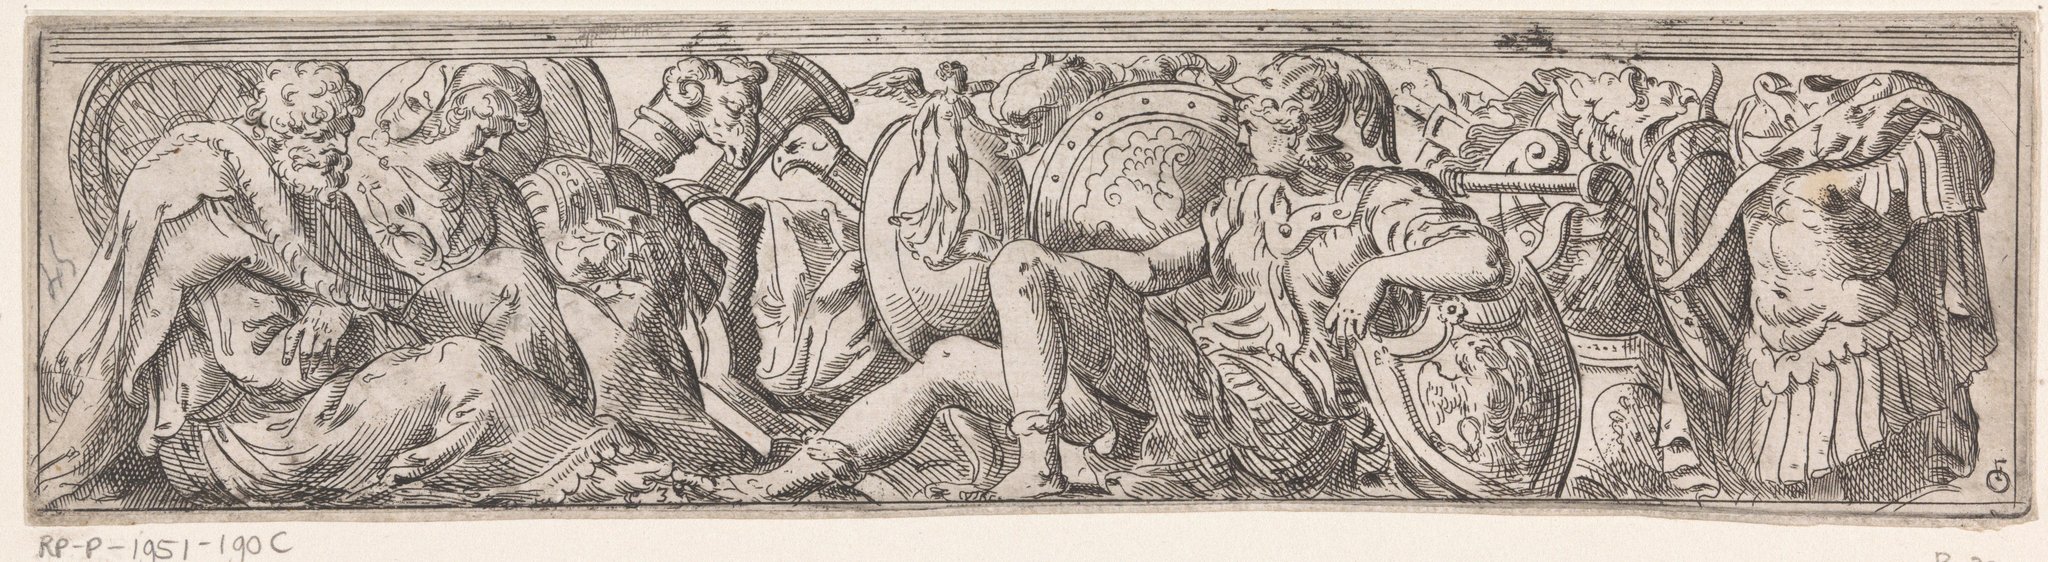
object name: print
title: Figuren tussen wapens en vazen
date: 1583-1638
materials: paper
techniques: etching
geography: vatican city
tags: sitting figure, weapons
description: Prent uit een reeks van vijf prenten, plus titelprent.